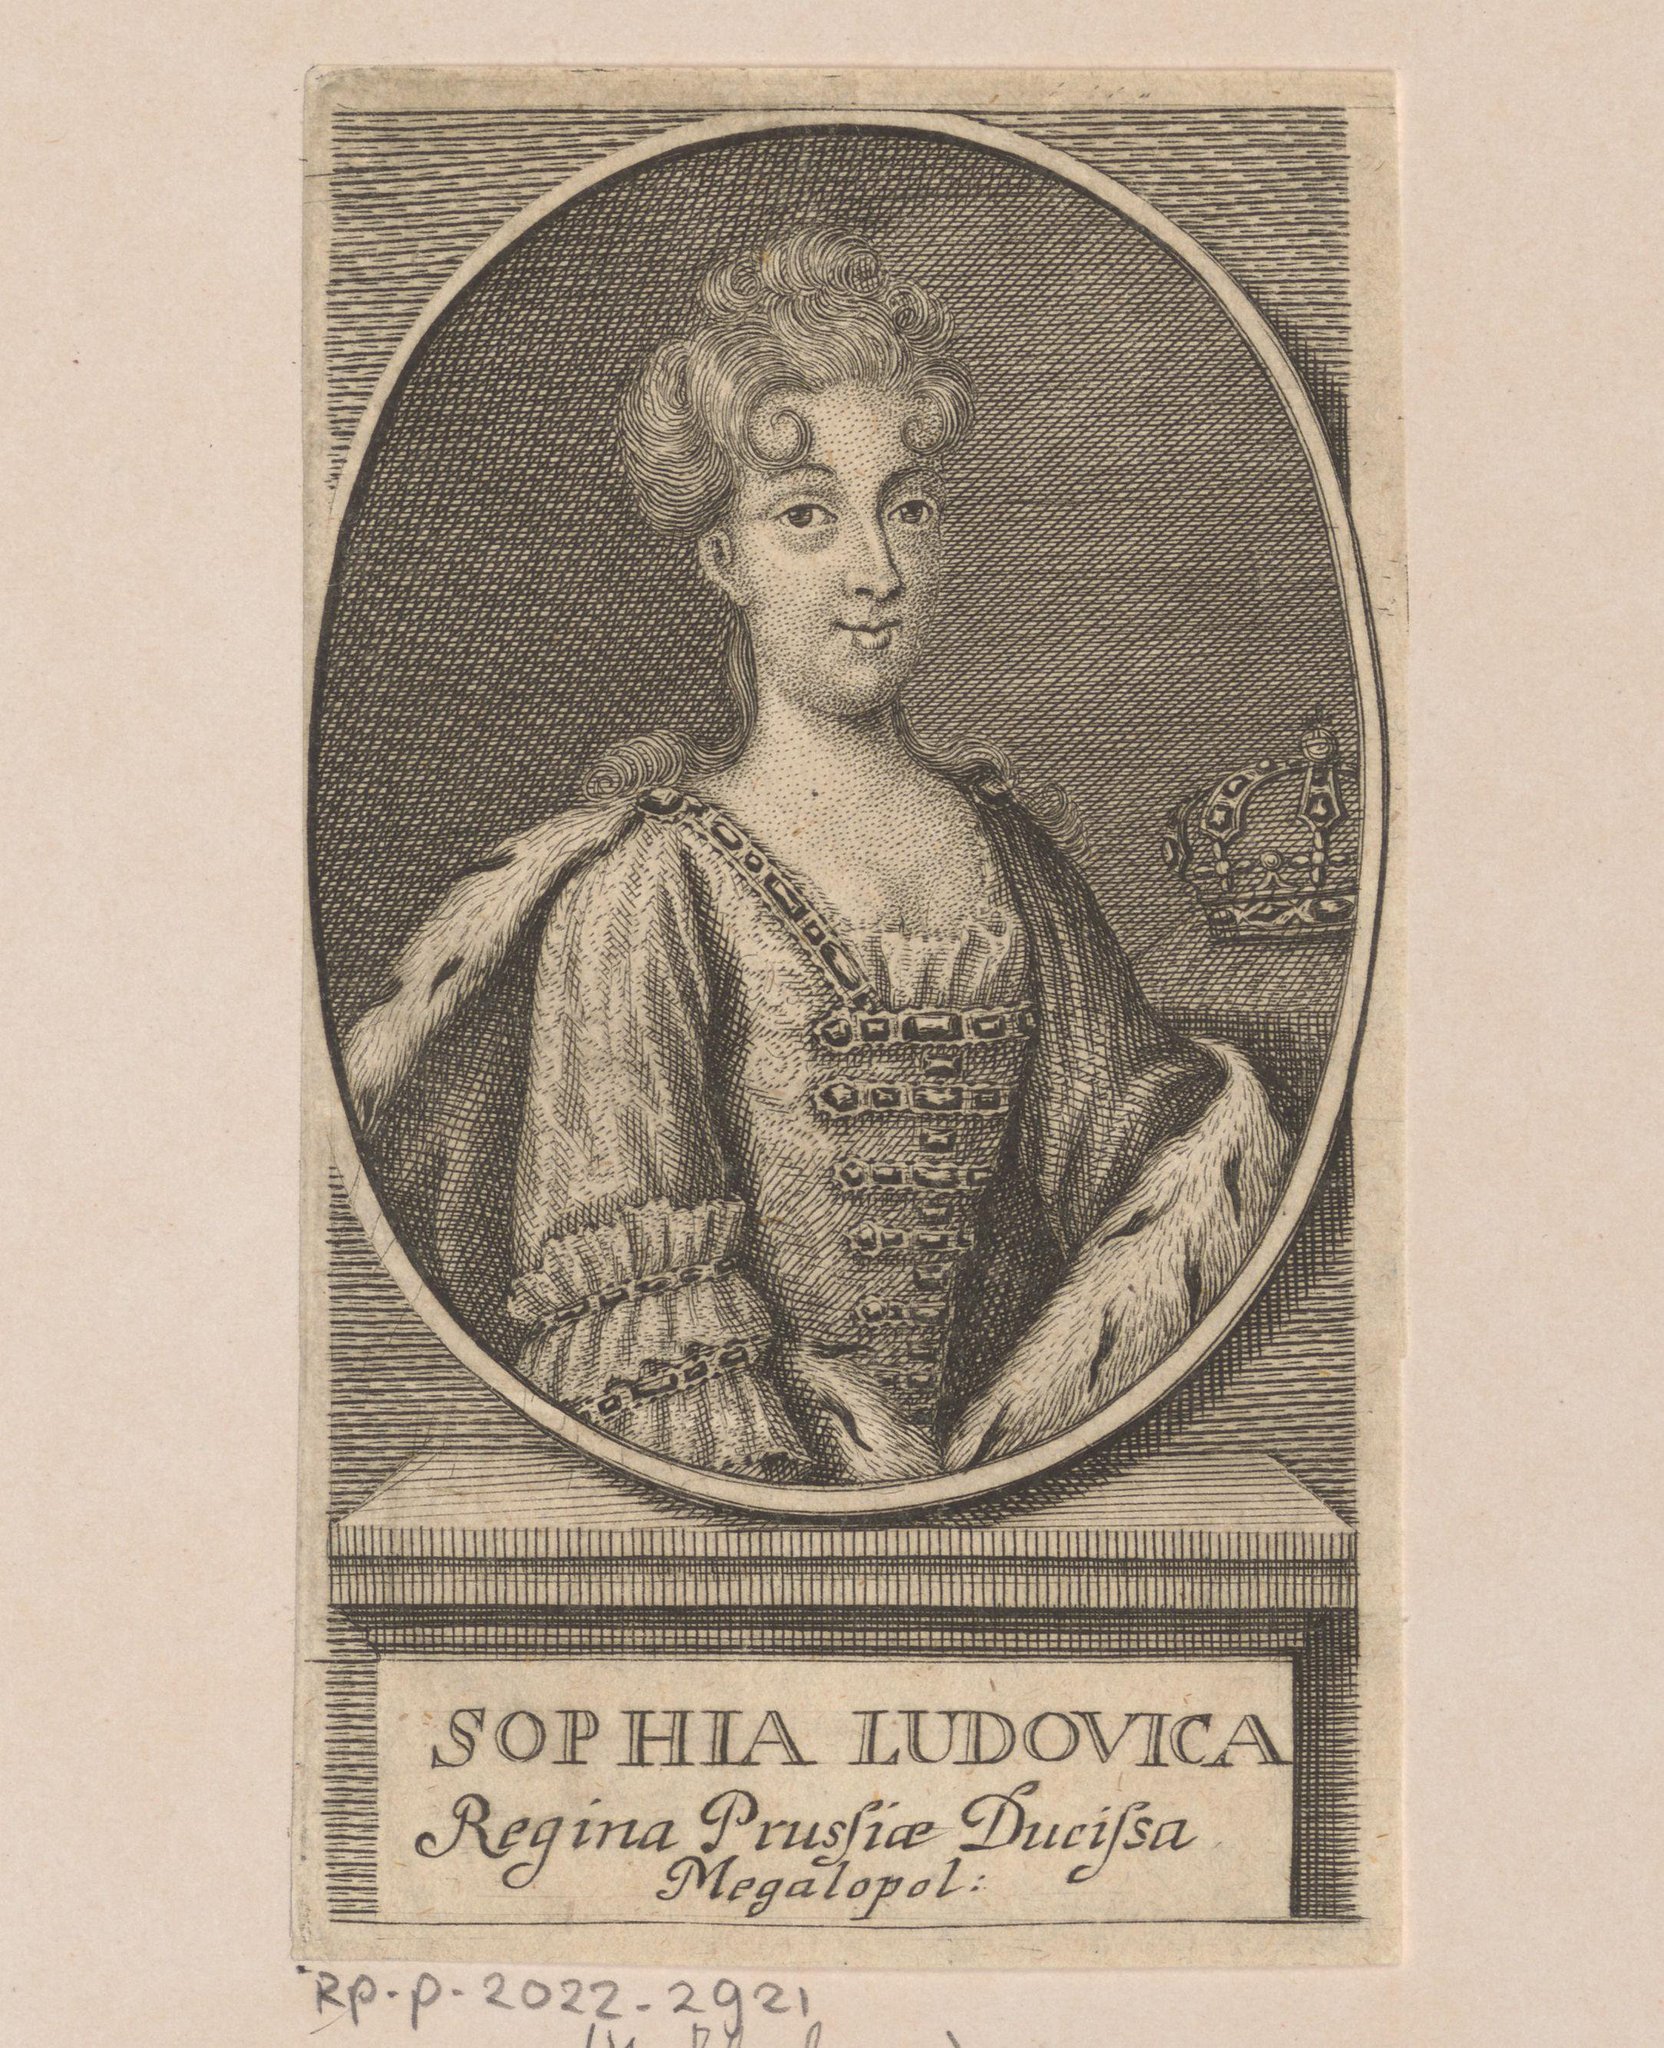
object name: print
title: Portret van Sophie Luise von Mecklenburg-Schwerin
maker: Anonymous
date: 1710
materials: paper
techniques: engraving, etching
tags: historical persons - bb - woman, queen, empress, etc. (wife of a ruler)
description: Prent waarschijnlijk uit: Abel, Kaspar. Preußische Und Brandenburgische Staats-Historie. Leipzig/Stendal: Ernst Heinrich Campen, 1710.